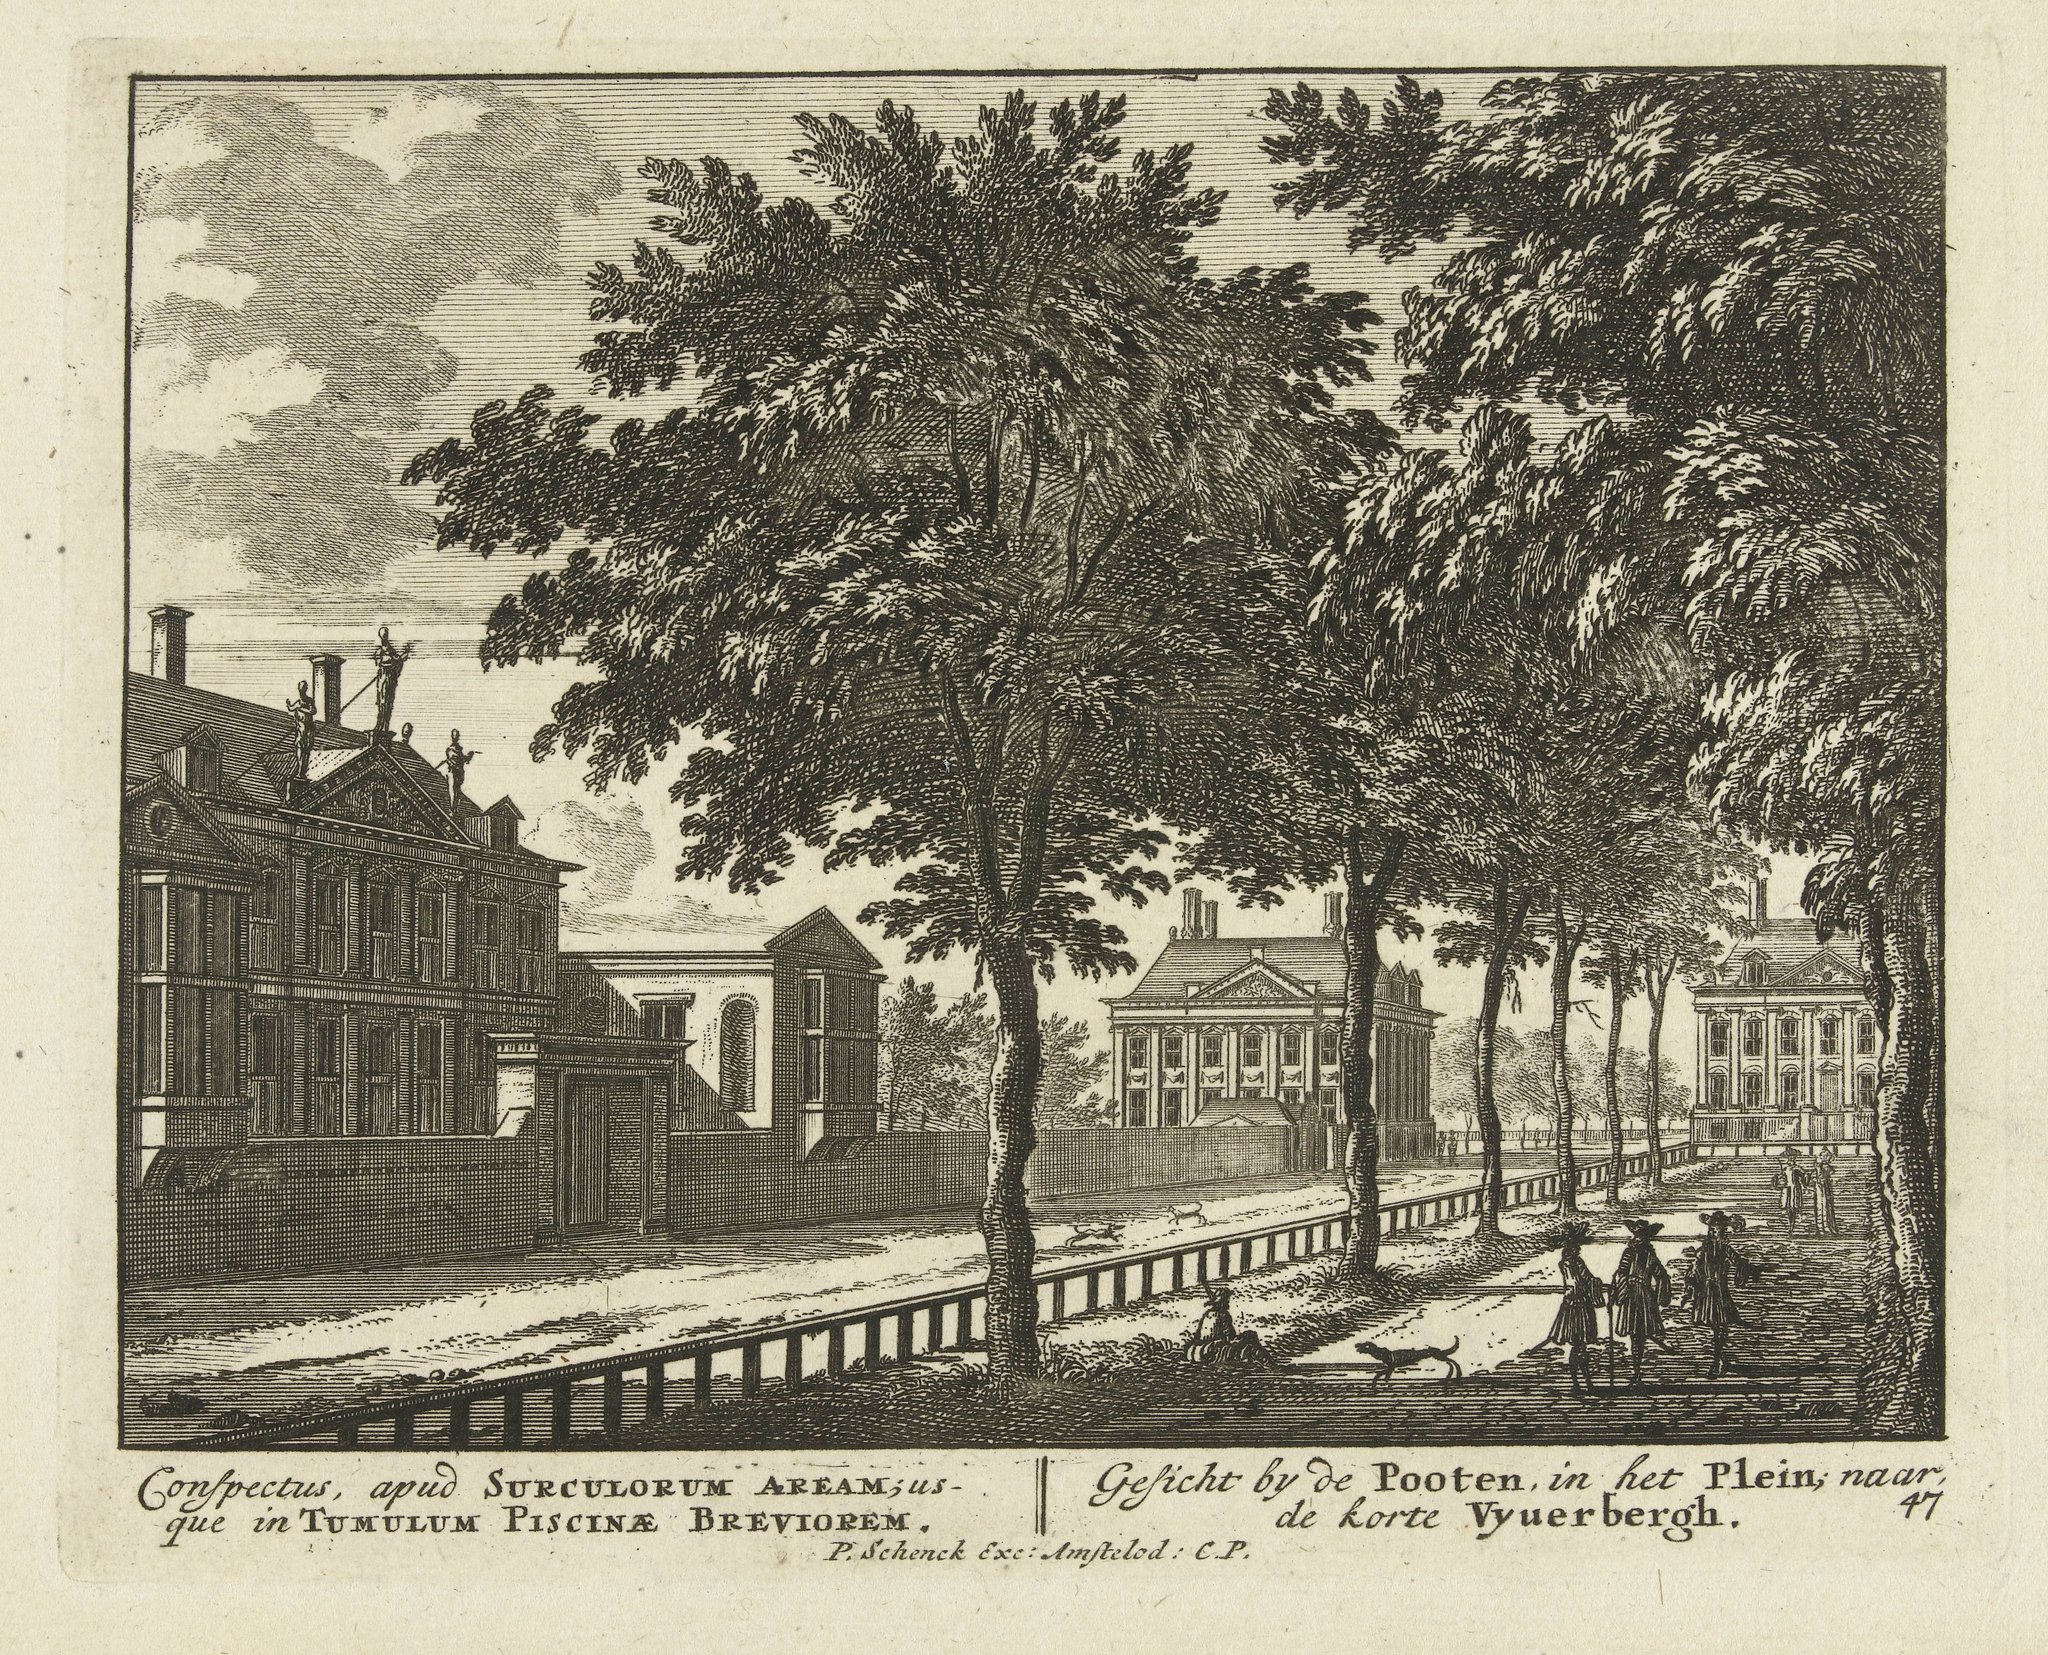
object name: print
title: Vermakelijke Gesigten van het overschone 's-Gravenhage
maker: pieter schenk (i)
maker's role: print maker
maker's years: 1660-1711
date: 1695-1705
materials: paper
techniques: etching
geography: amsterdam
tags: street, the hague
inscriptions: collector's mark: Lugt 2228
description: Prent uit een serie van 71 prenten met Rijnlandschappen, gezichten op vorstelijke paleizen en stadsgezichten uit Den Haag en Amsterdam.